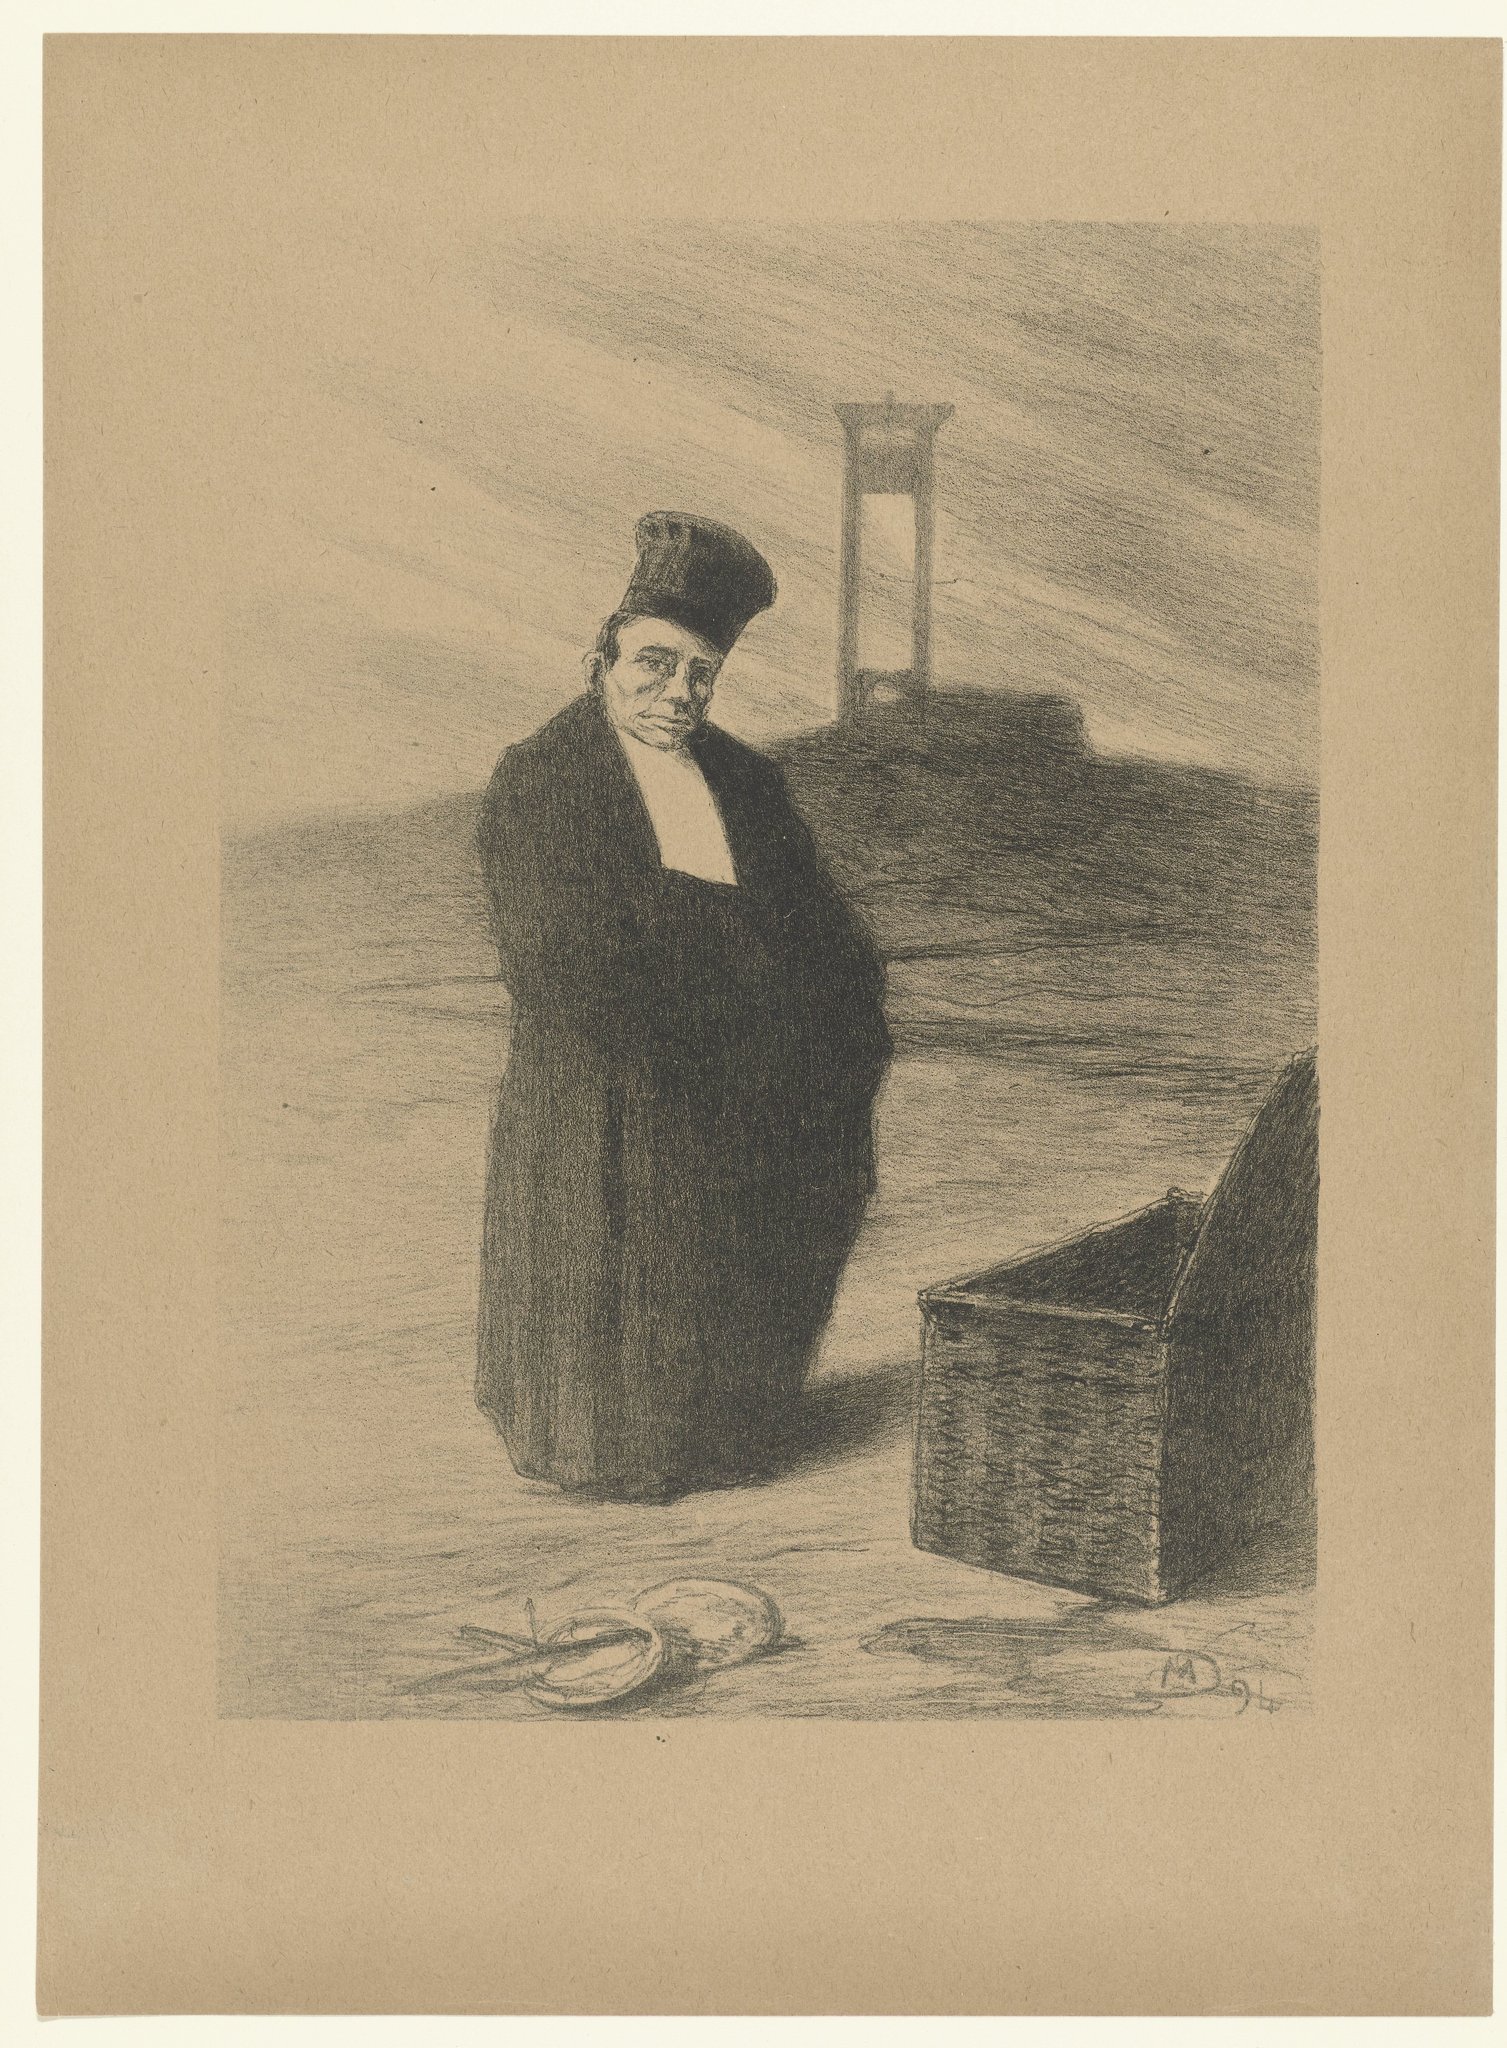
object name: print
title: Rechter voor guillotine met mand en weegschaal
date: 1894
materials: paper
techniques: lithograph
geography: paris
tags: violent death ~ beheading by guillotine, law and jurisprudence (+ judge), violent death, being killed; being mishandled and maltreated; seeking death (+ instrument of execution)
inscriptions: collector's mark: Lugt 2760, collector's mark: Lugt 2228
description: Satire op rechtspraak met rechter die naast een grote mand staat met een opgeklapt deksel. Uit de mand lijkt bloed te stromen. Op de grond ligt een weegschaal en achter de rechter is het silhouette van een guillotine zichtbaar.